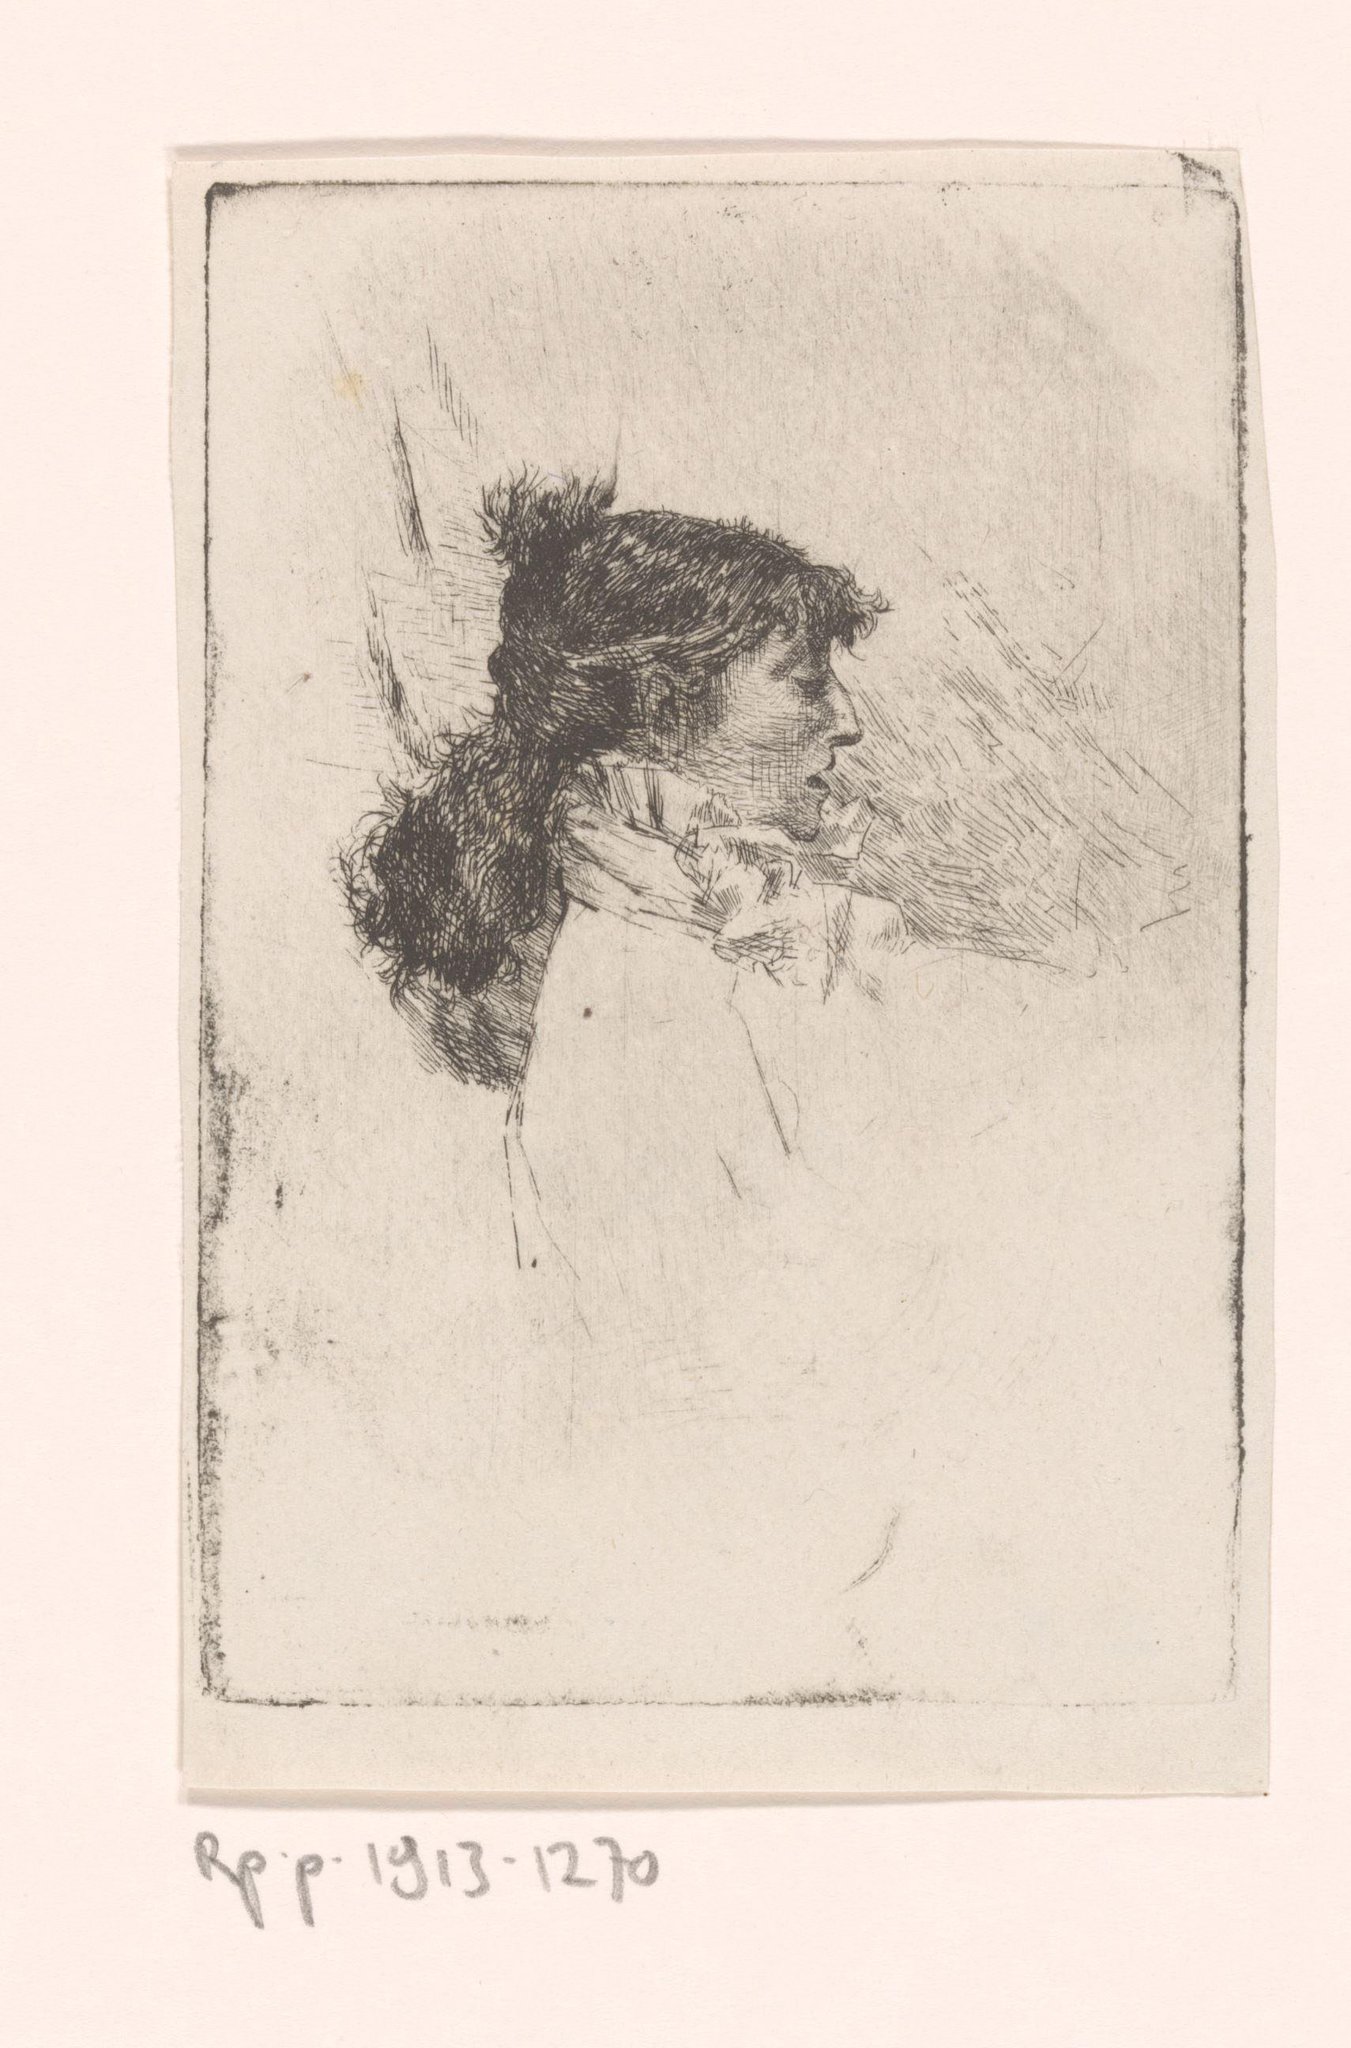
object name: print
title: Portret van Sarah Bernhardt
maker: philip zilcken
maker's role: draughtsman, painter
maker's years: 1857-1930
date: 1867-1890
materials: paper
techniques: drypoint, etching, intaglio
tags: paris, sculptor, sarah bernhardt, historical persons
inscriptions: collector's mark: Lugt 2233